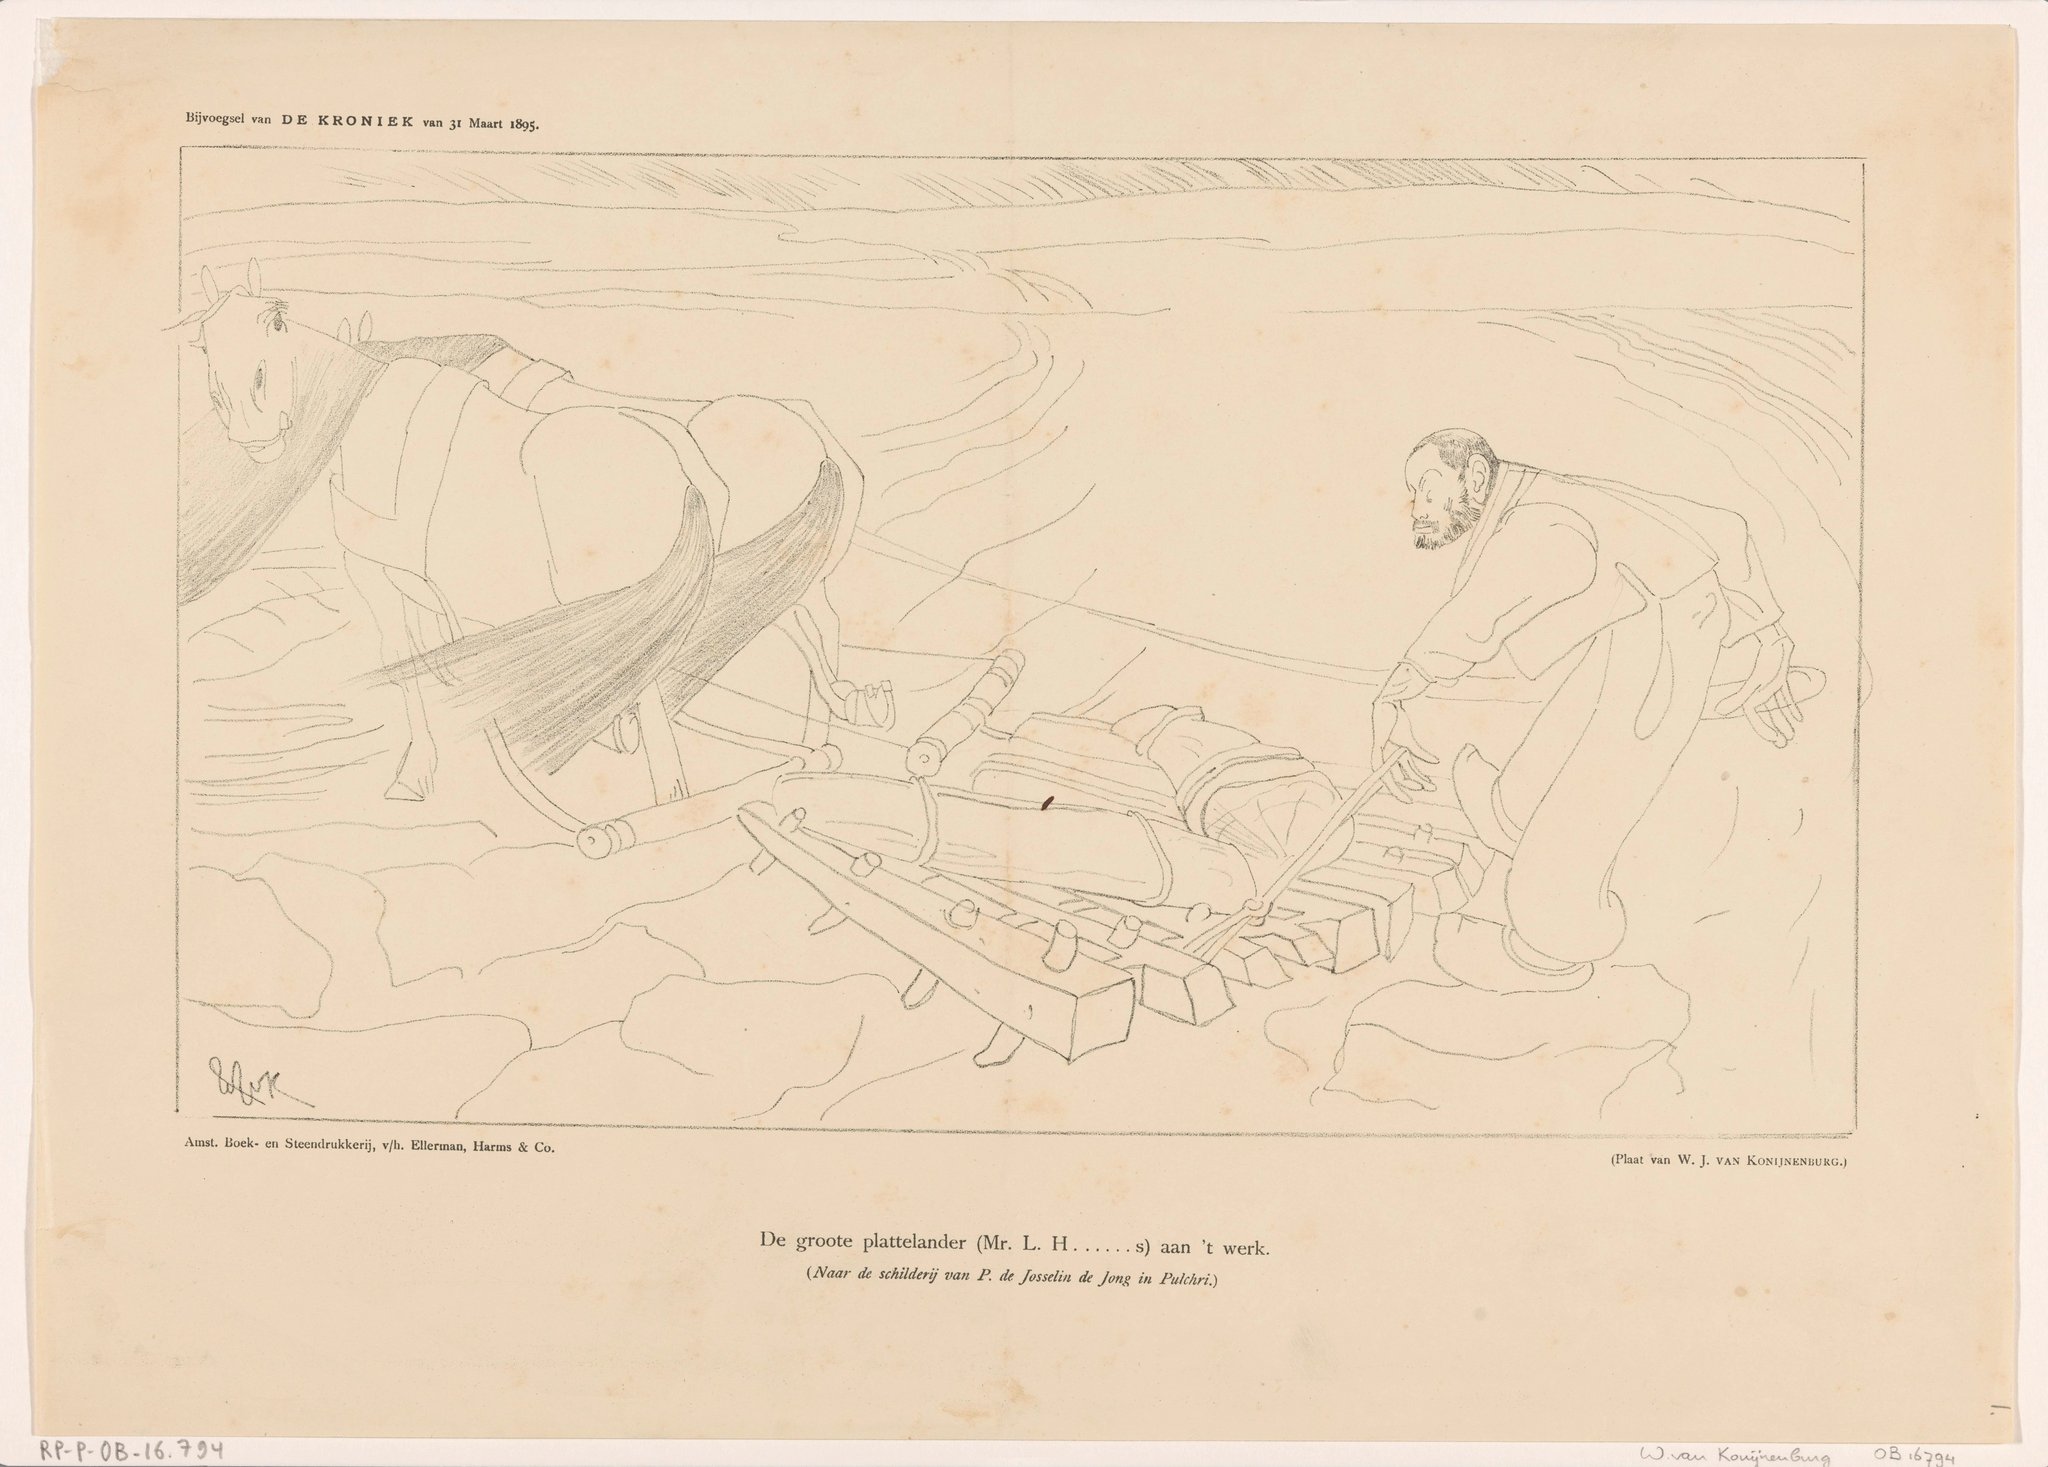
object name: print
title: De groote plattelander (Mr. L. H......s) aan 't werk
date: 1895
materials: paper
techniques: lithograph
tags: horse, ploughing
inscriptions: collector's mark: Lugt 2228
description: Twee paarden trekken een ploeg voort over een akker. Achter de ploeg loopt een man.